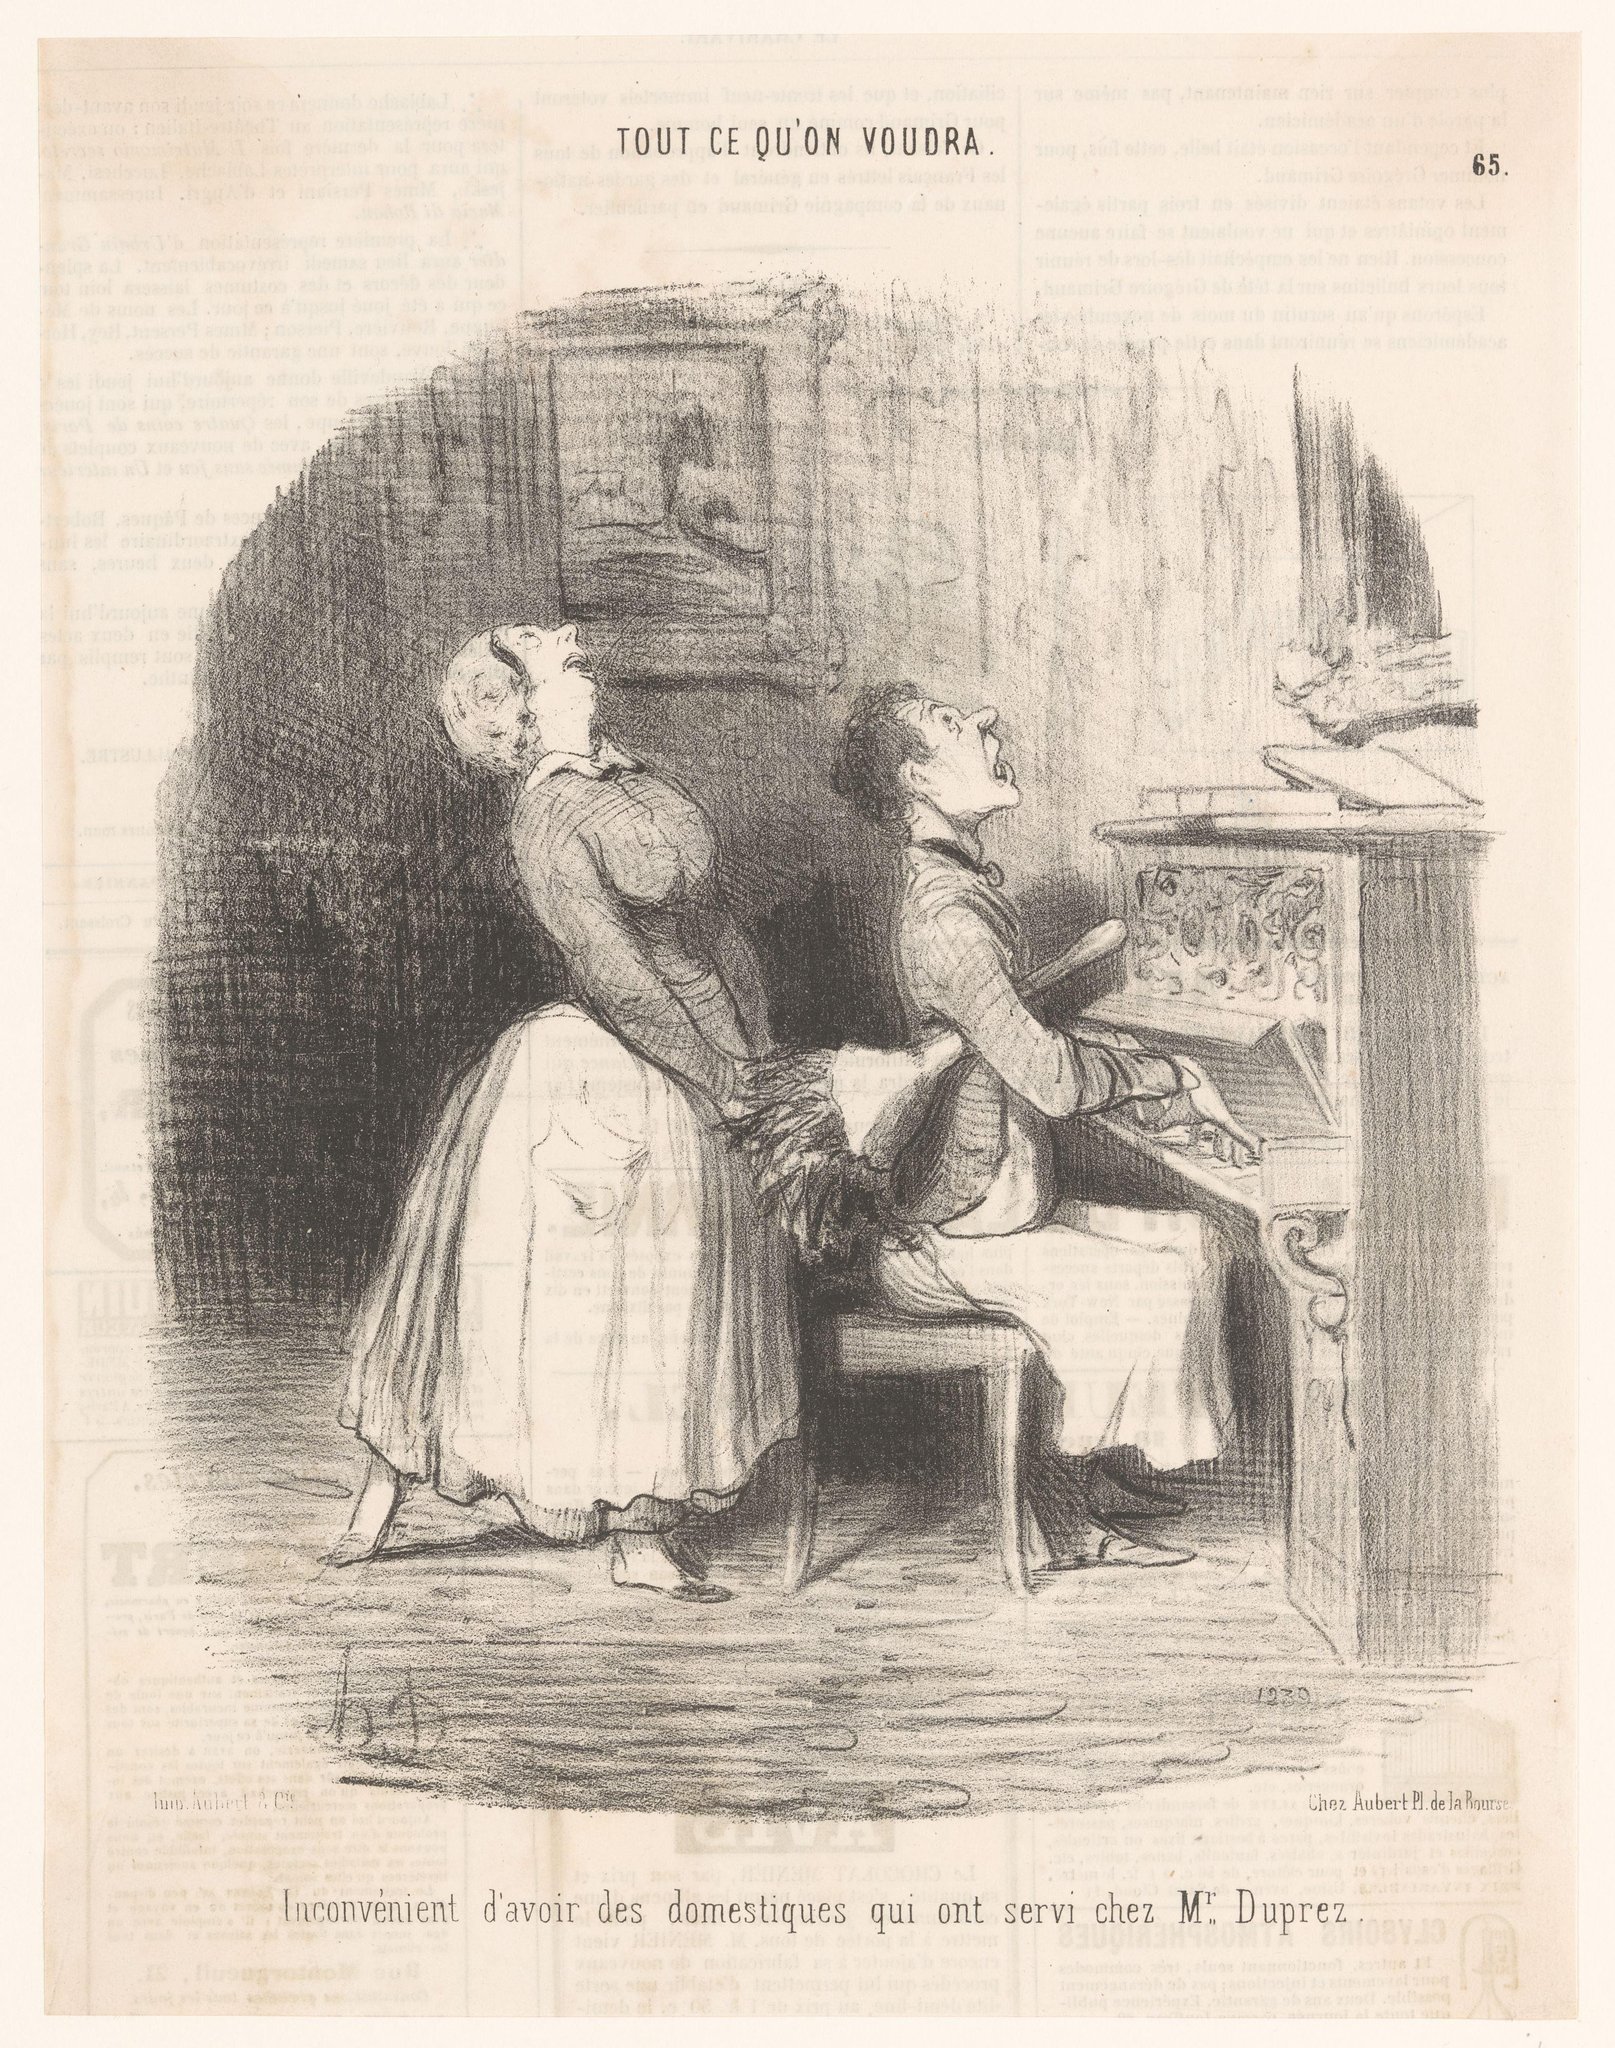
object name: cartoon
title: Wenselijke en onwenselijke situaties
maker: honoré daumier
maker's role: draughtsman, painter, print maker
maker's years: 1808-1879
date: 1850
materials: paper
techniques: lithograph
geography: paris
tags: caricatures (human types), vocal music, singing, pianoforte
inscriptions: collector's mark: Lugt 2228a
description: Prent gebruikt voor: Le Charivari, 28 maart 1850.